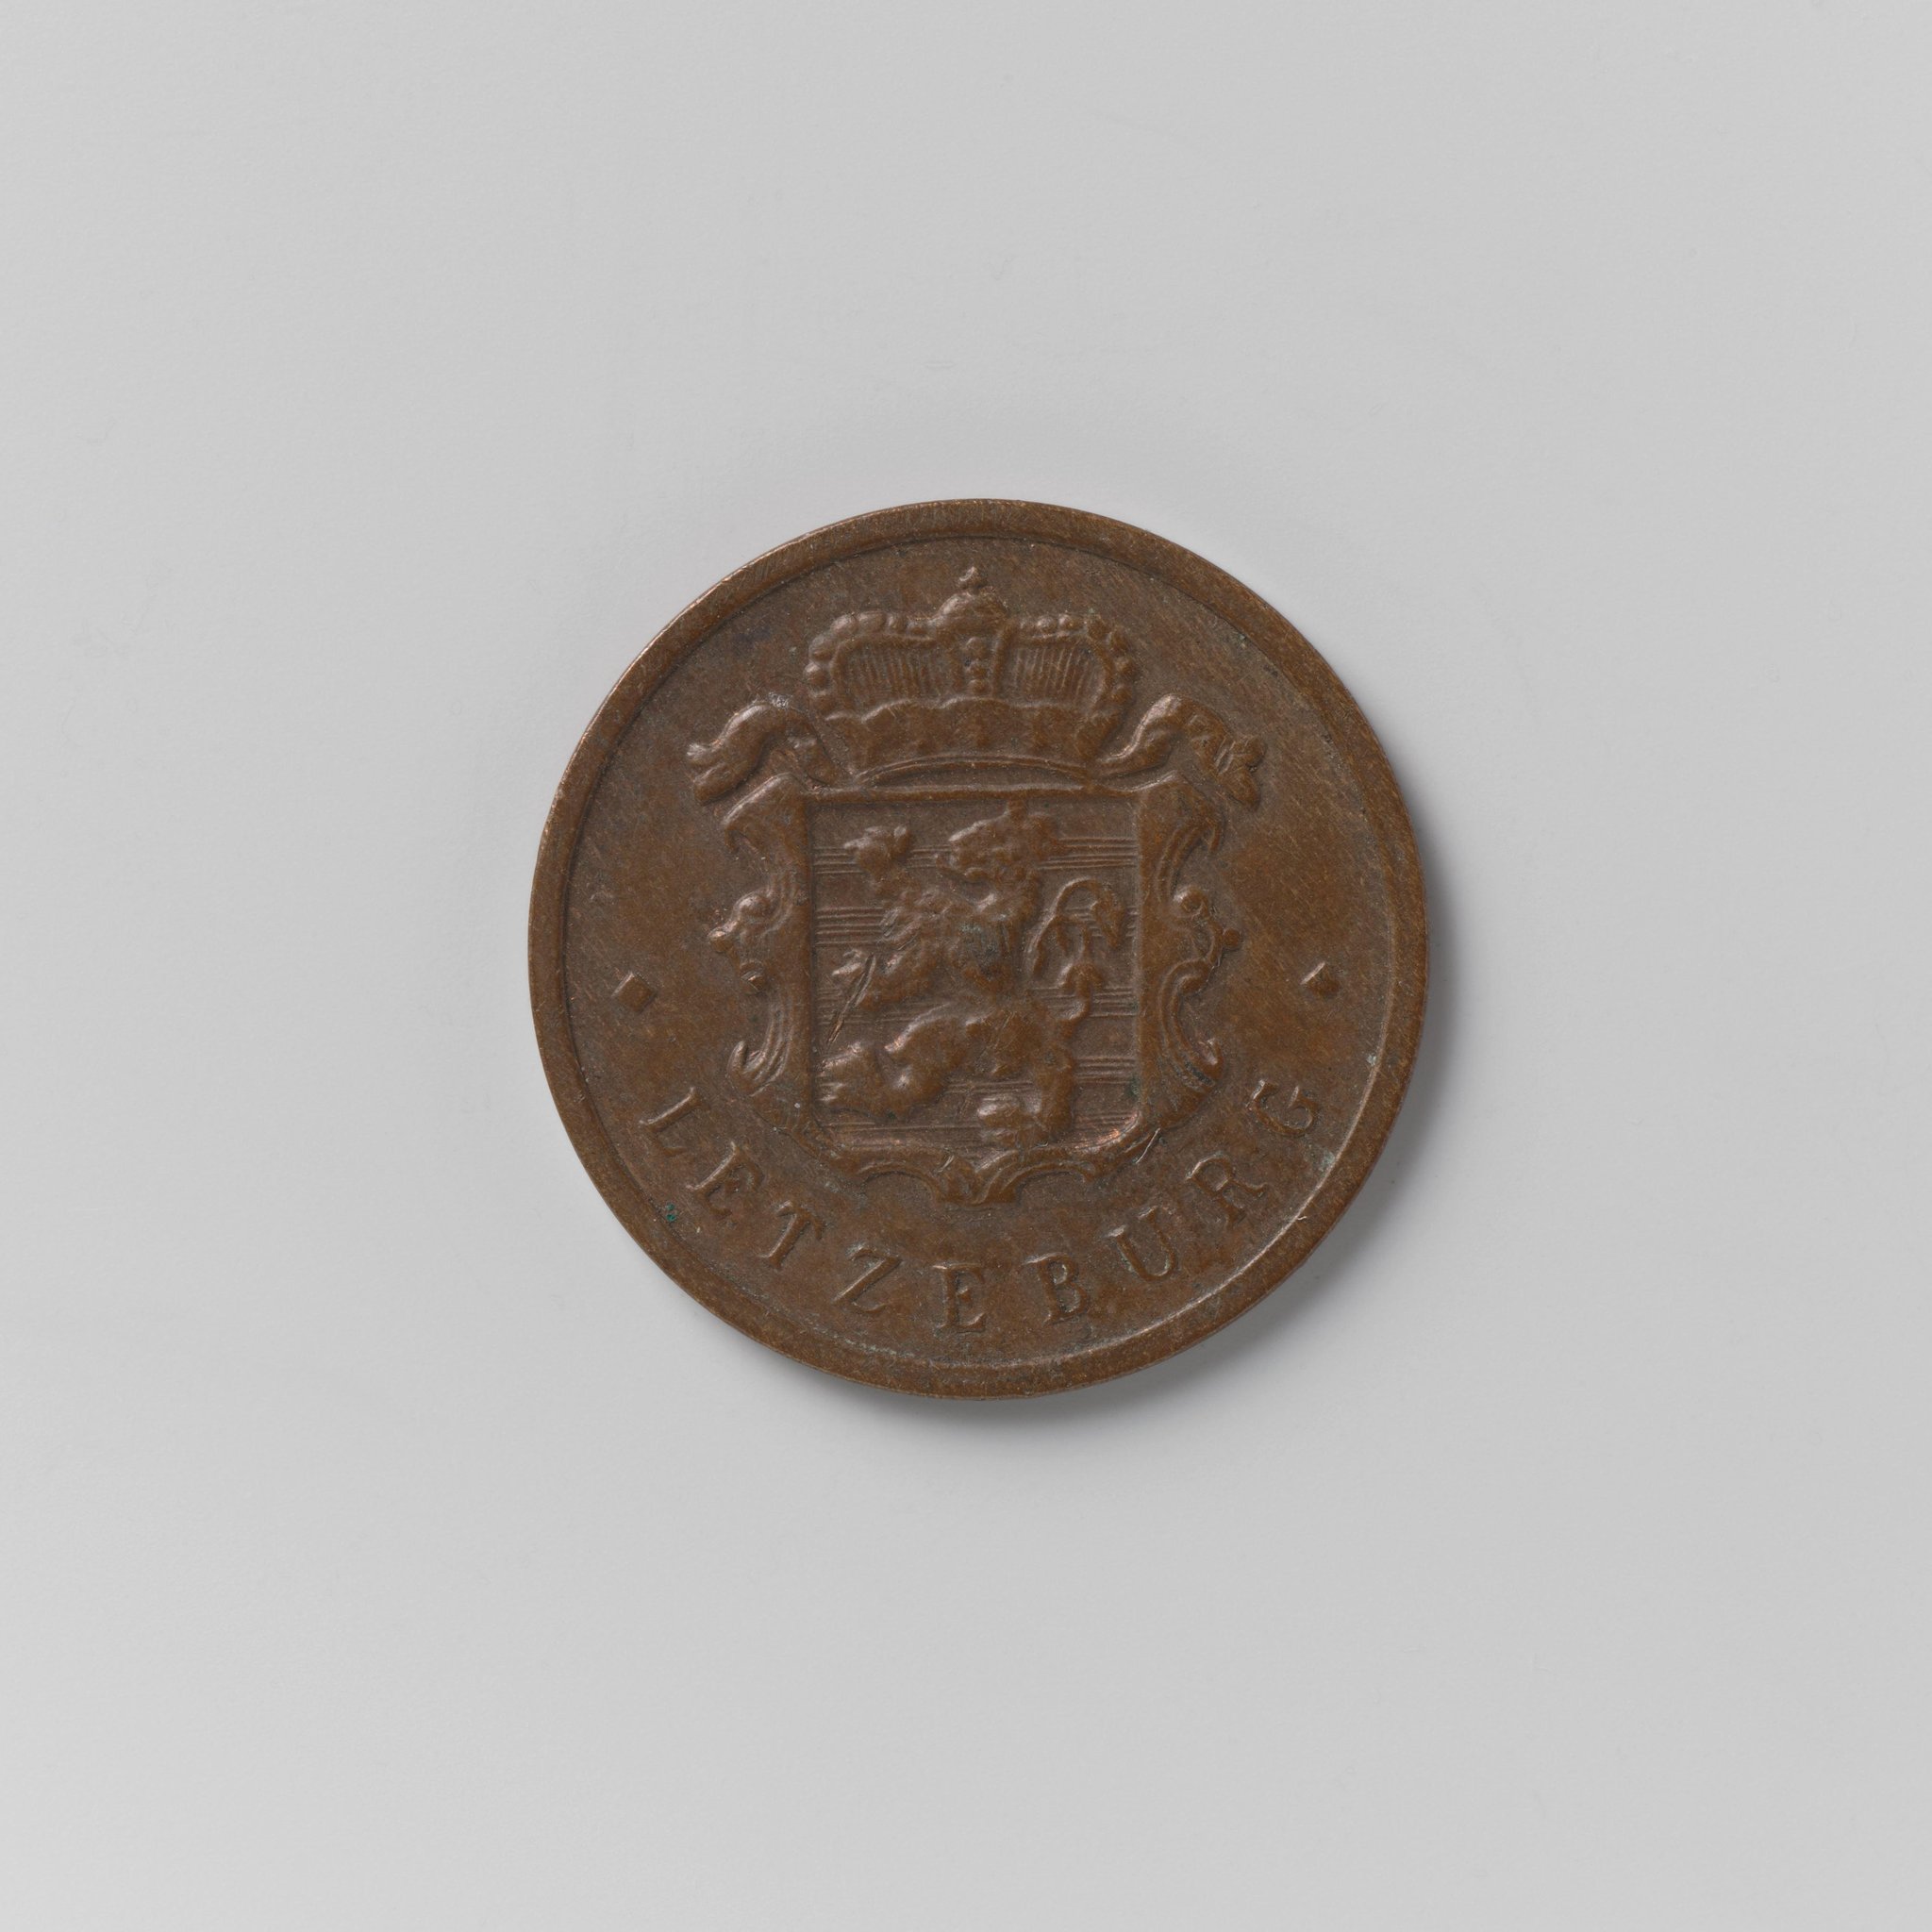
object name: vijfentwintig centime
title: Luxemburgse 25 centimes van Charlotte, 1947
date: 1947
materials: bronze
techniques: striking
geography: brussels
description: Bronzen munt. Voorzijde: gekroond versierd wapenschild. Keerzijde: rechts van tak in twee regels waarde-aanduiding, waaronder jaartal. Gladde rand.